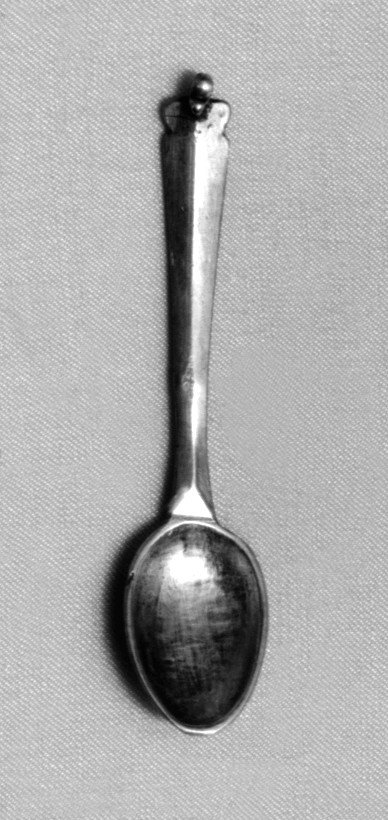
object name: snuff spoon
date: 1701-1733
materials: gilt, silver